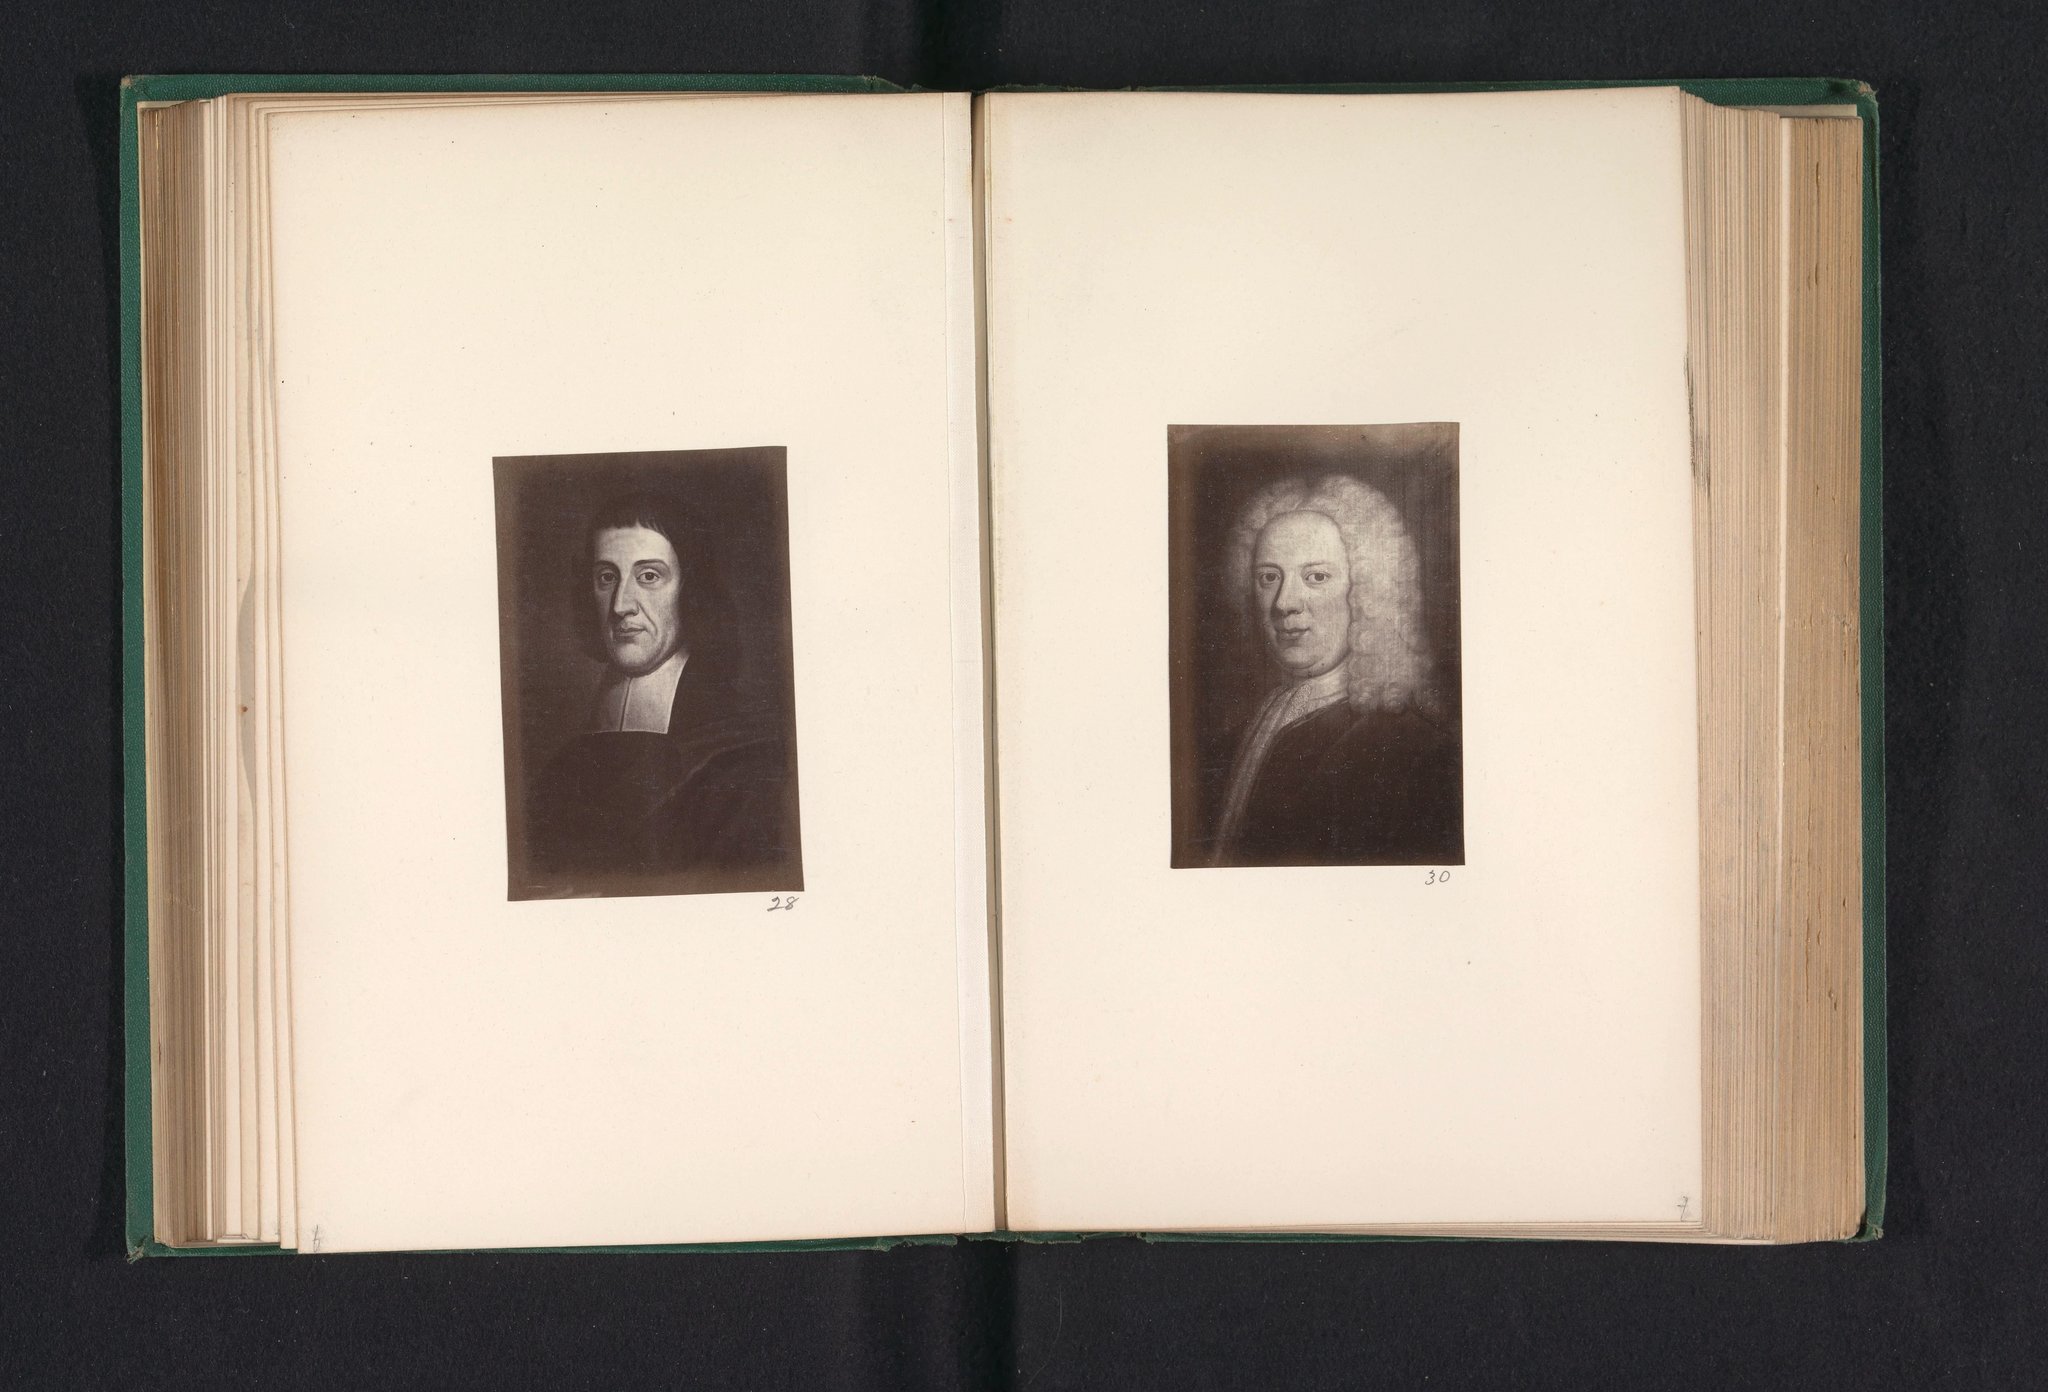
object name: photograph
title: Fotoreproductie van een schilderij, voorstellende een portret van John Anderson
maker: thomas annan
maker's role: fotograaf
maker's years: 1829-1887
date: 1863-1868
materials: photographic support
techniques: albumen print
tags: historical persons (portraits and scenes from the life) (+ (full) bust portrait)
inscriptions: number: ‘28’